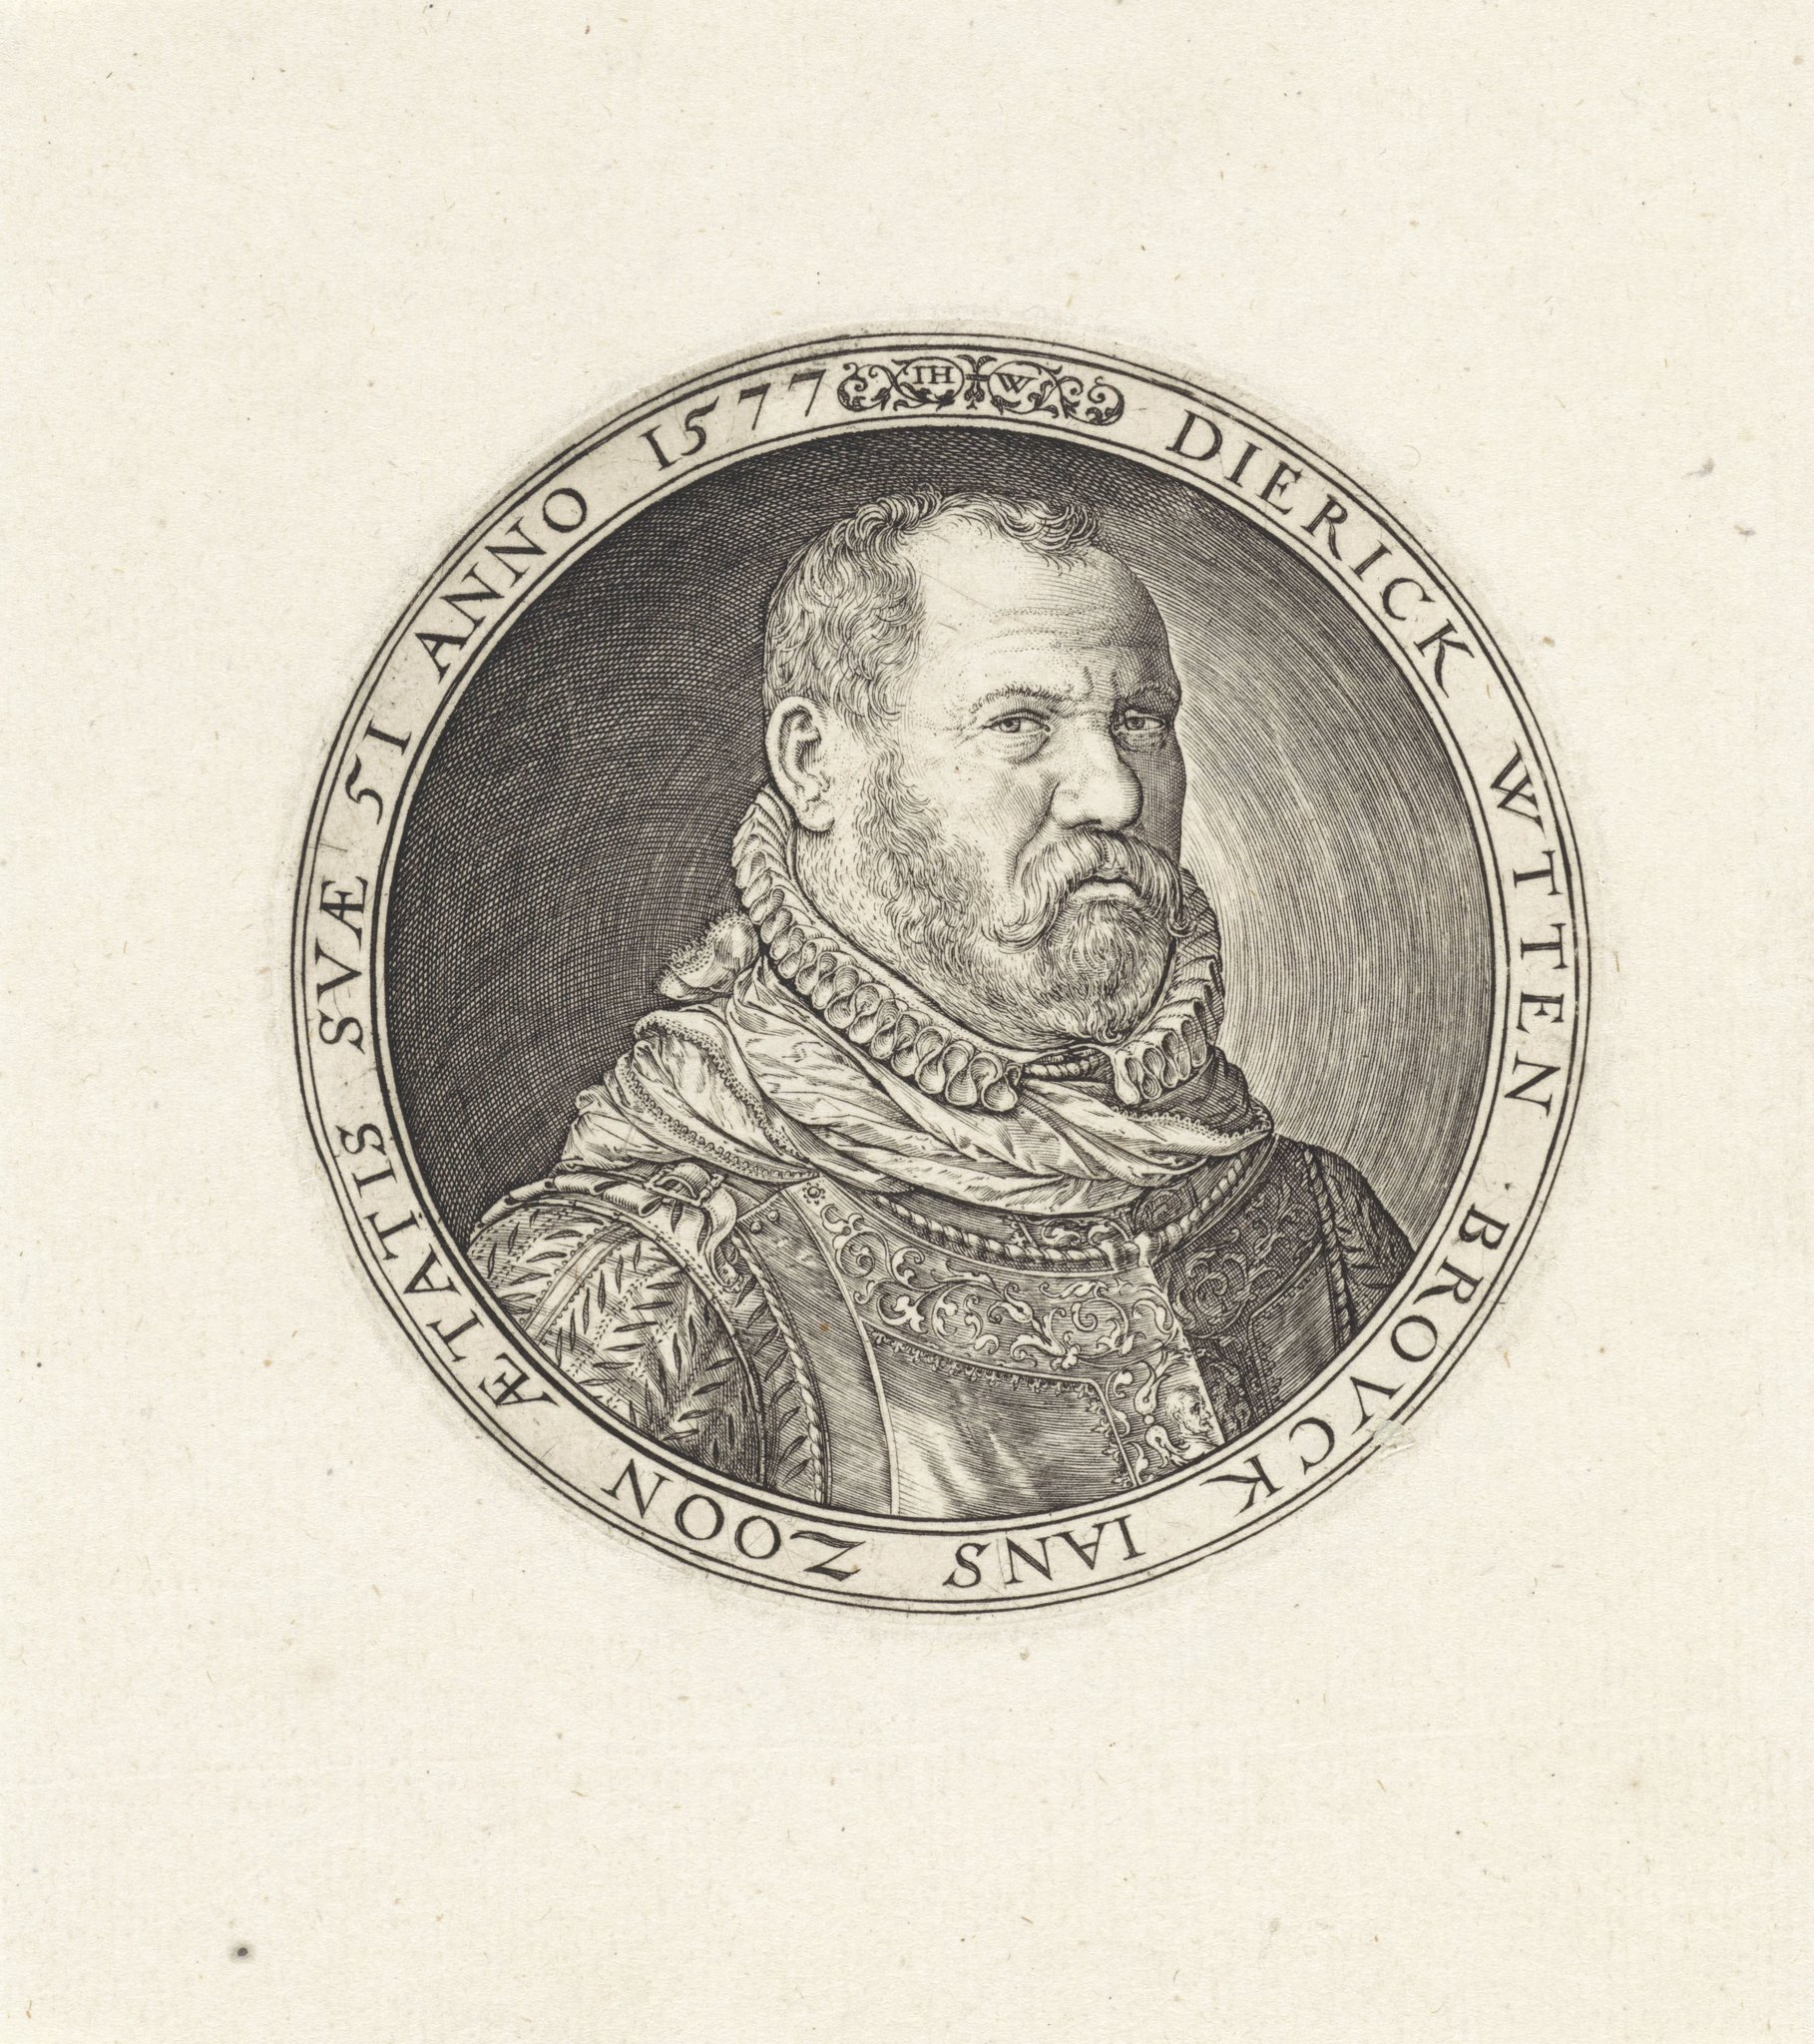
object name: print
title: Portret van Dirck Jansz. Uyttenbroeck, burgemeester van Delft, op 51-jarige leeftijd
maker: johannes wierix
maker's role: draughtsman, print maker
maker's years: 1549-1618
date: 1577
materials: paper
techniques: engraving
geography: delft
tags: mayor, armour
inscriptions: collector's mark: Lugt 2228